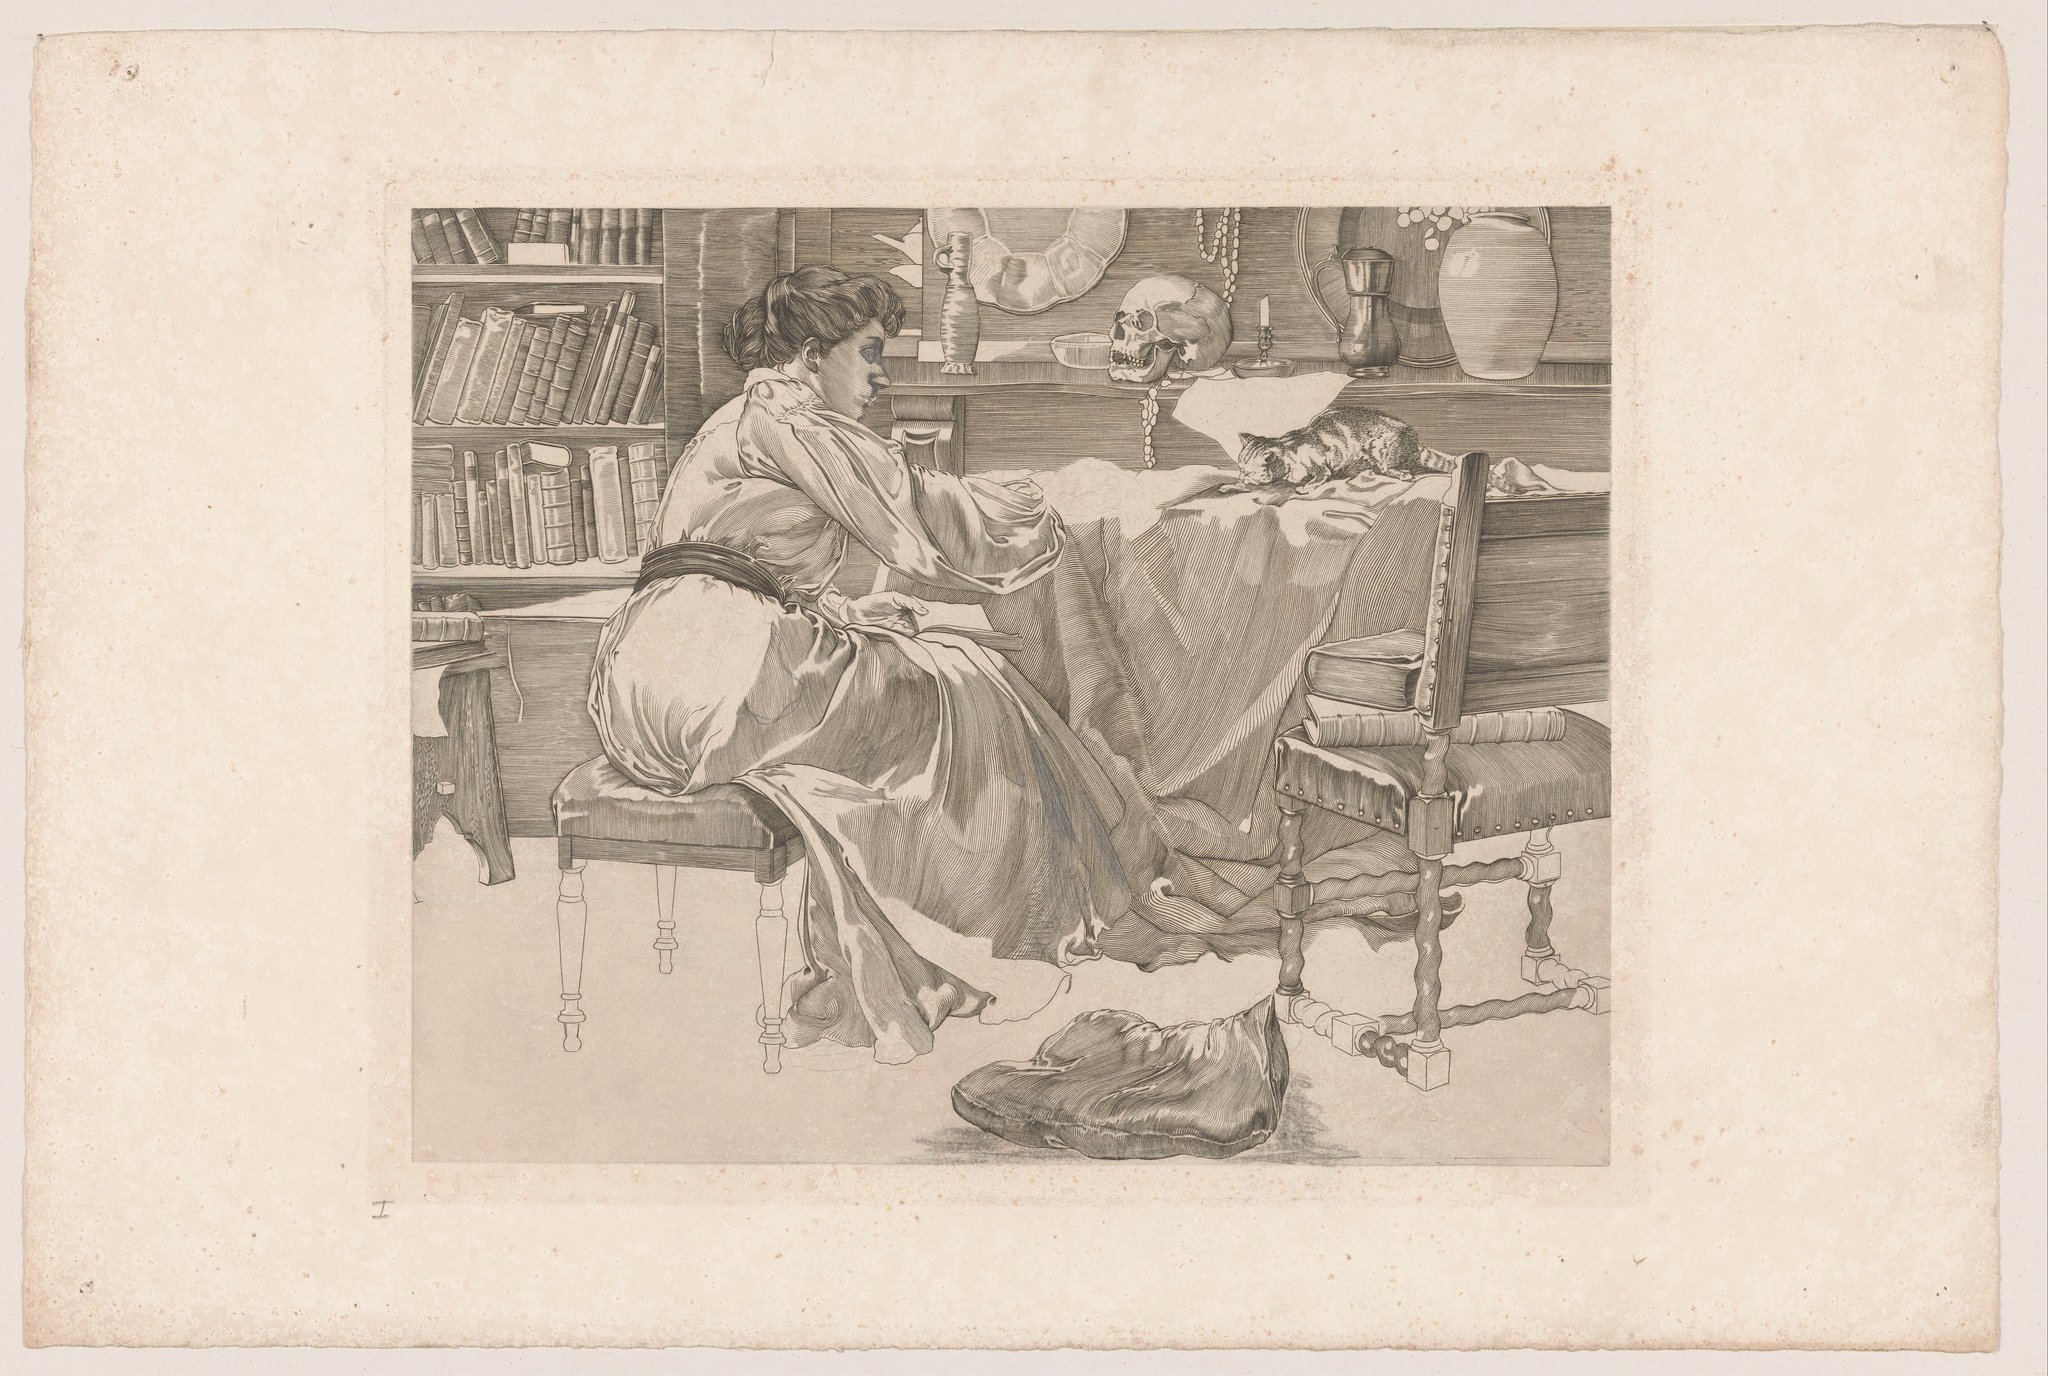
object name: print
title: Vrouw en kat in atelier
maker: johannes josephus aarts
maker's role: draughtsman, print maker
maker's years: 1871-1934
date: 1881-1934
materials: chalk, paper, pencil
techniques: engraving, intaglio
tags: cat, (human) skull, workshop, studio ~ painter, book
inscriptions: collector's mark: Lugt 2228, collector's mark: Lugt 2166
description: Een vrouw in een jurk zit op een kruk aan een tafel met daarop een kat. Ze houdt een opengeslagen boek in haar linkerhand vast. Op de achtergrond een boekenkast en een dressoir met vazen, een schedel en een kaars in een kandelaar. Tegen de muur twee schalen.